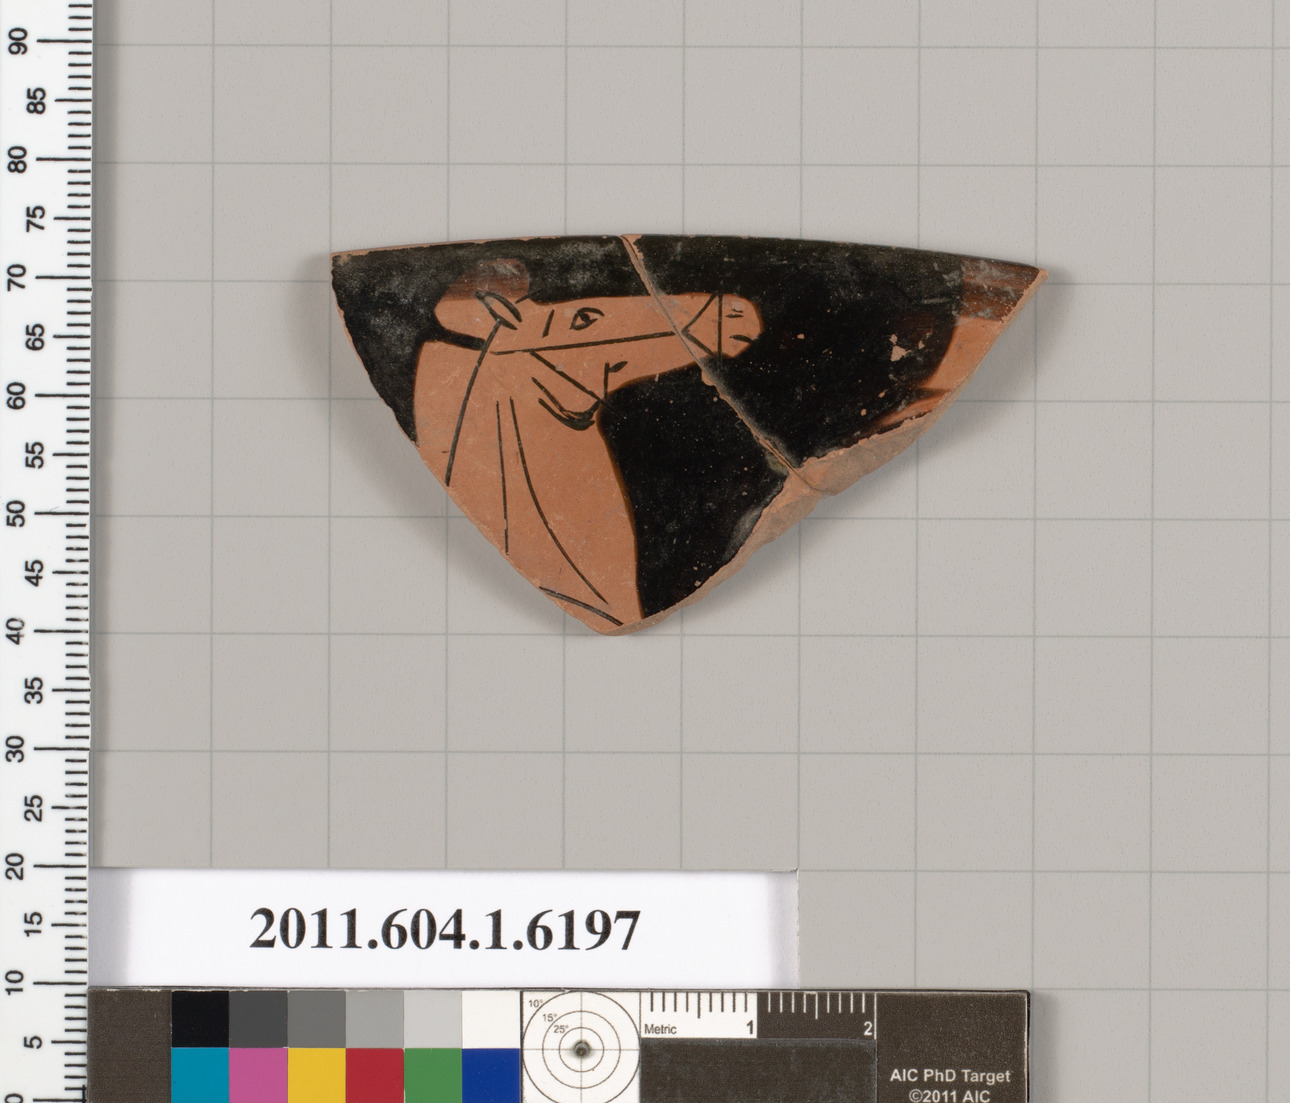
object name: kylix fragment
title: Terracotta rim fragment of a kylix (drinking cup)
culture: greek, attic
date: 510-500 BCE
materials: terracotta